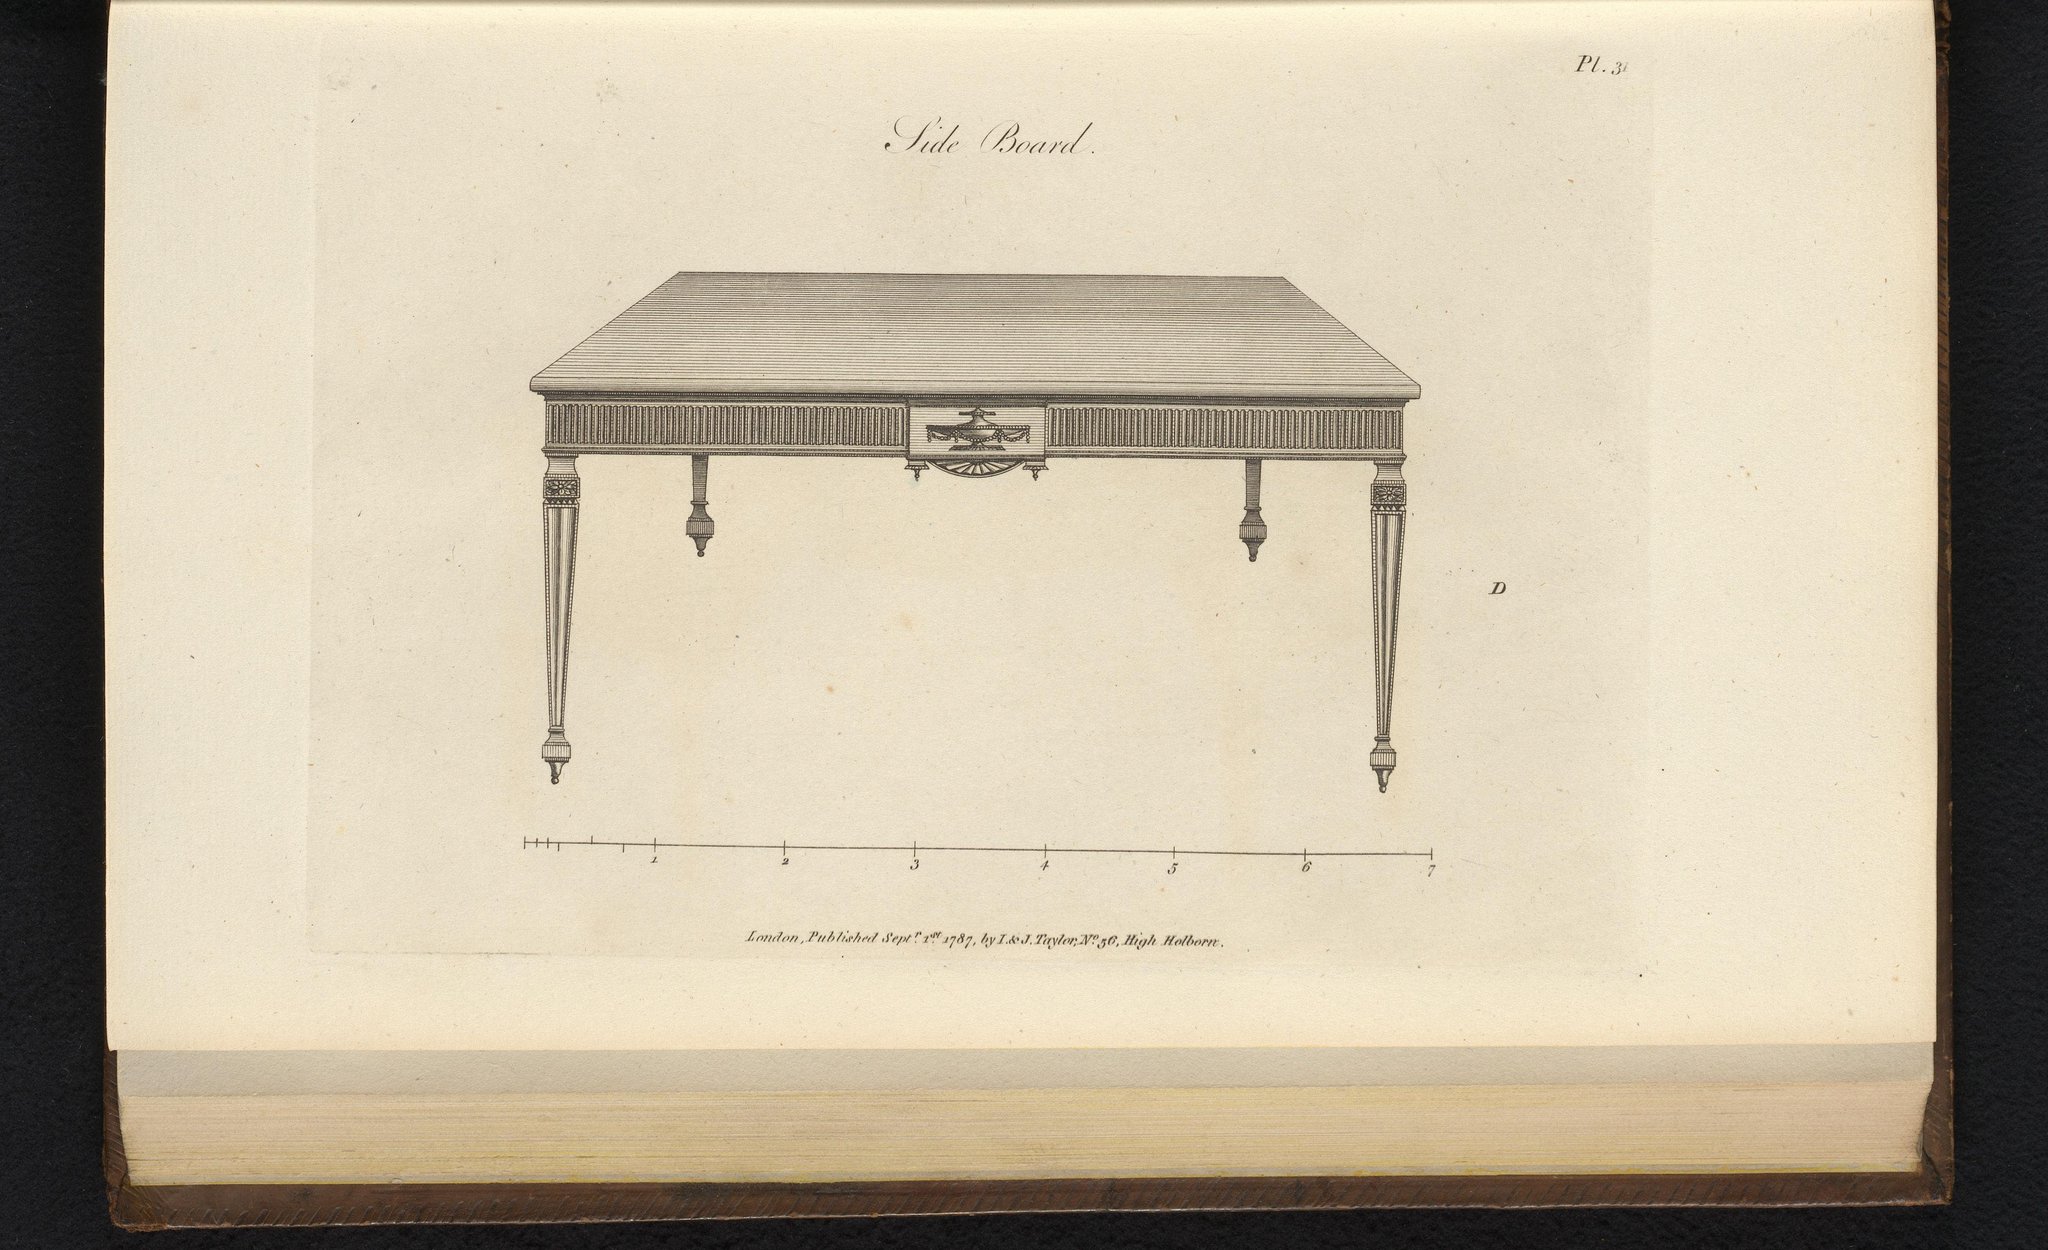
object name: page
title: Tafel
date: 1787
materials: paper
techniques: engraving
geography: holborn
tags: writing-table, writing-desk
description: Genummerd: Pl. 31. Tafel gemerkt: D. Schaalverdeling in de ondermarge. Prent maakt deel uit van een boek.